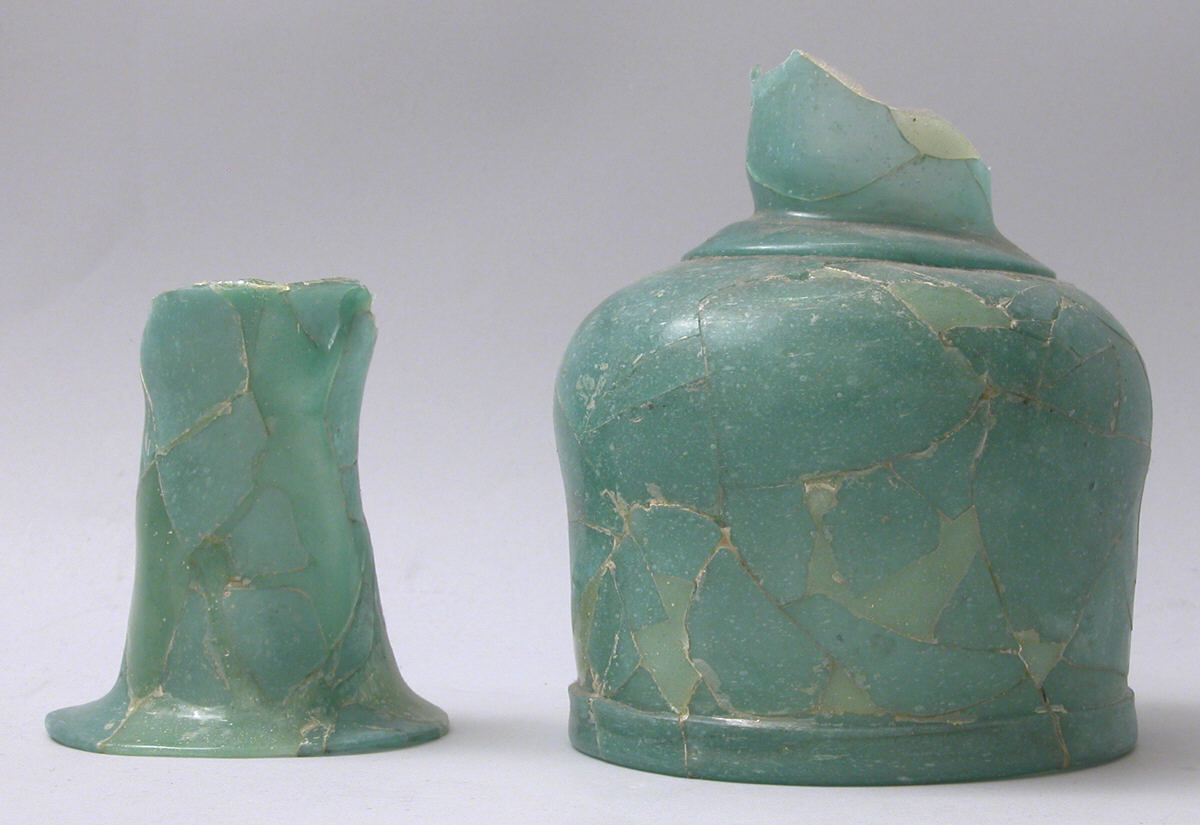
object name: chalice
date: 201-1200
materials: glass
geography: egypt